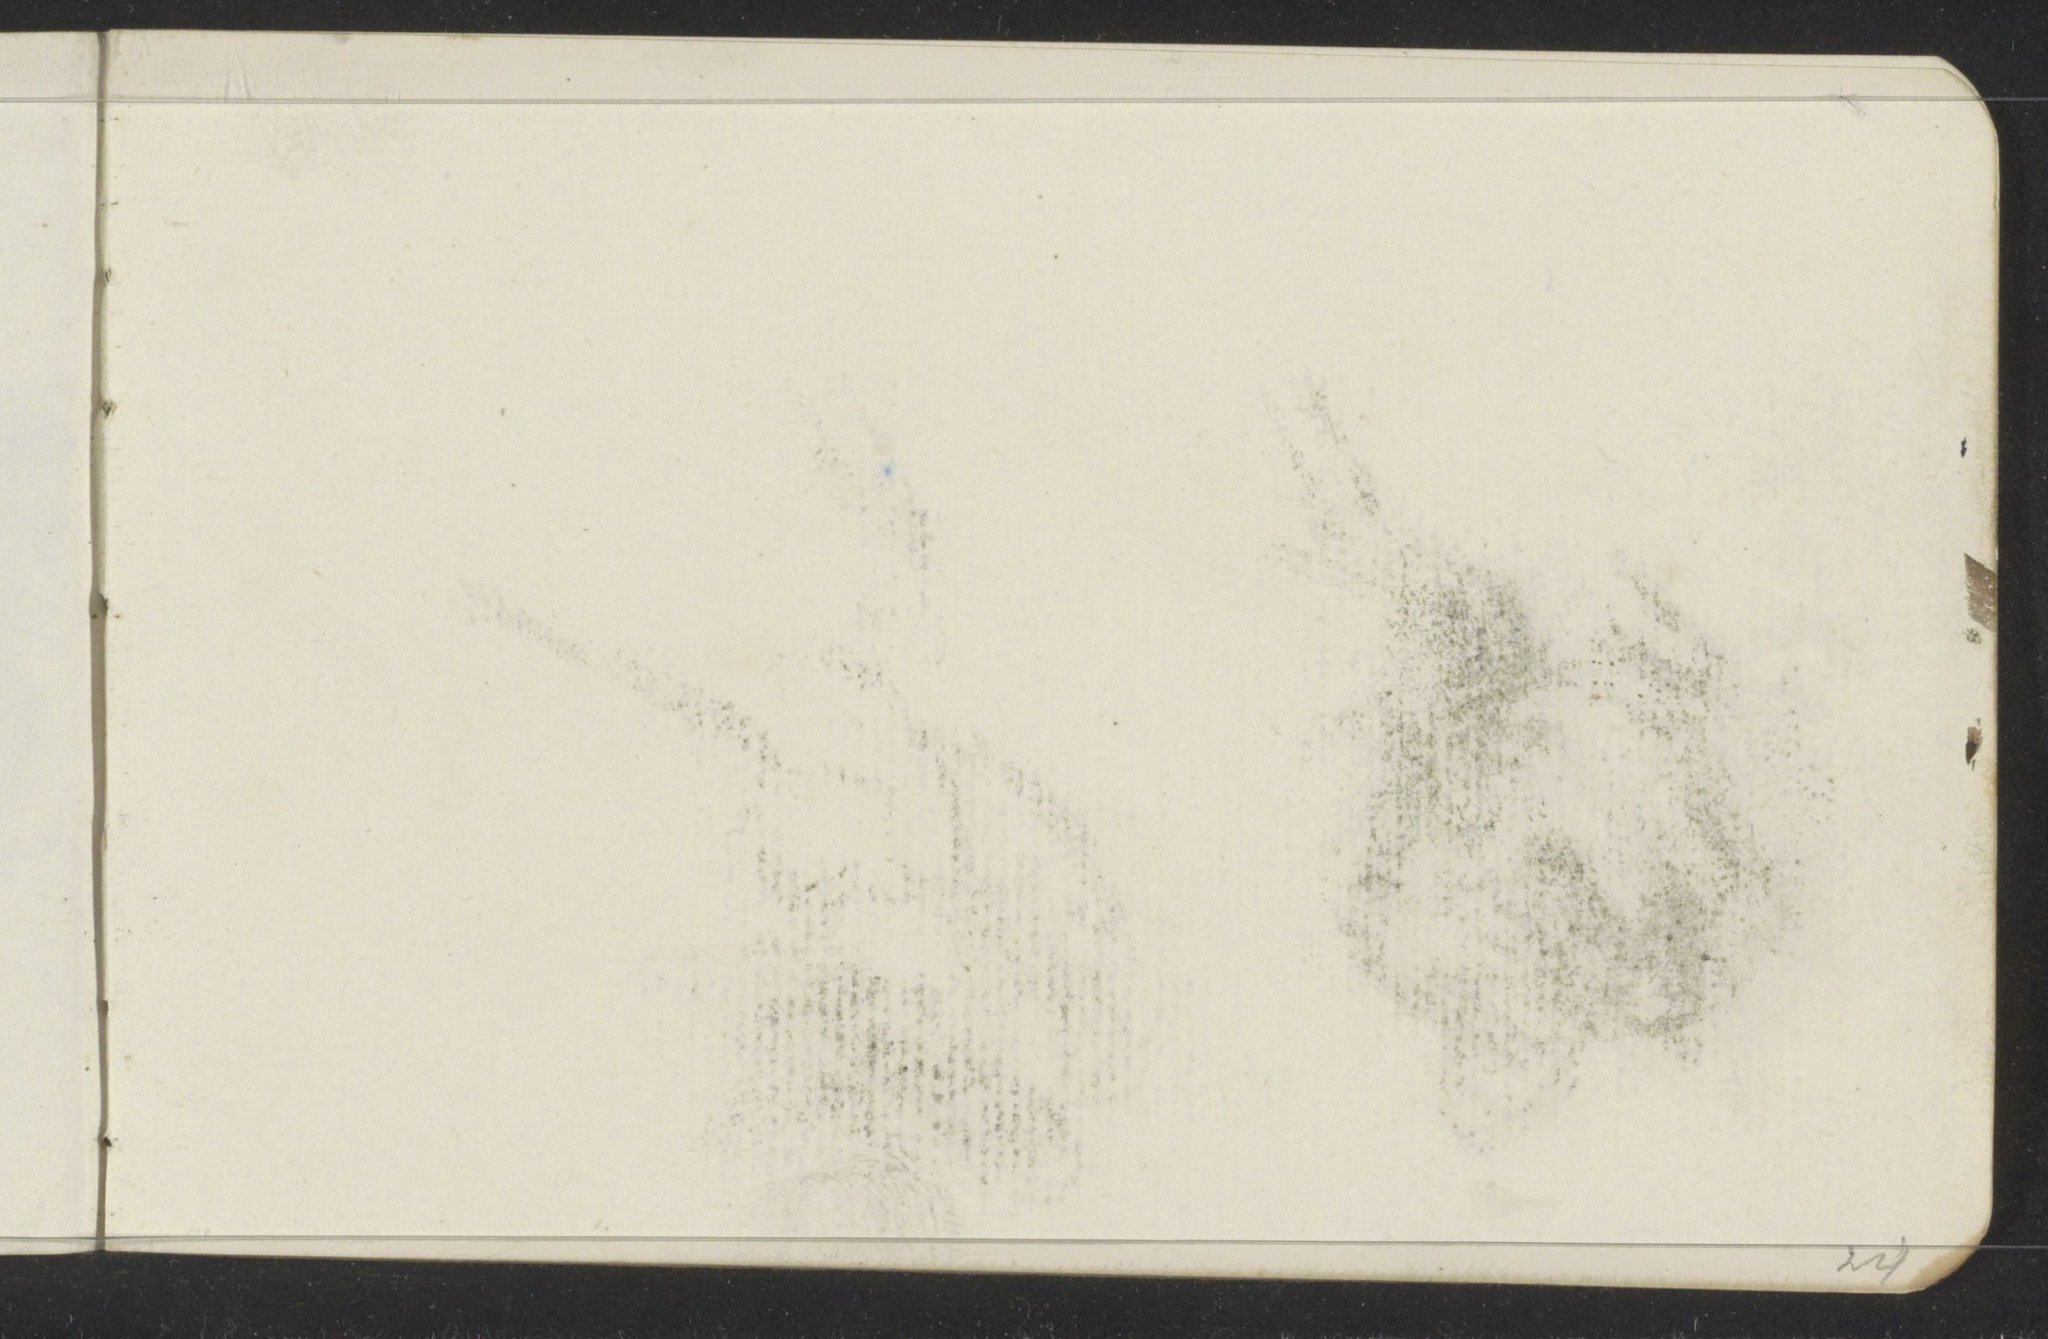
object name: sketchbook leaf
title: Abklatsch van de krijttekening op blad 23 verso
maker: isaac israels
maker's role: draughtsman, painter, print maker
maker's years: 1865-1934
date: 1875-1934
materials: paper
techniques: printmaking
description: Blad 24 recto uit schetsboek LXII met 28 bladen.